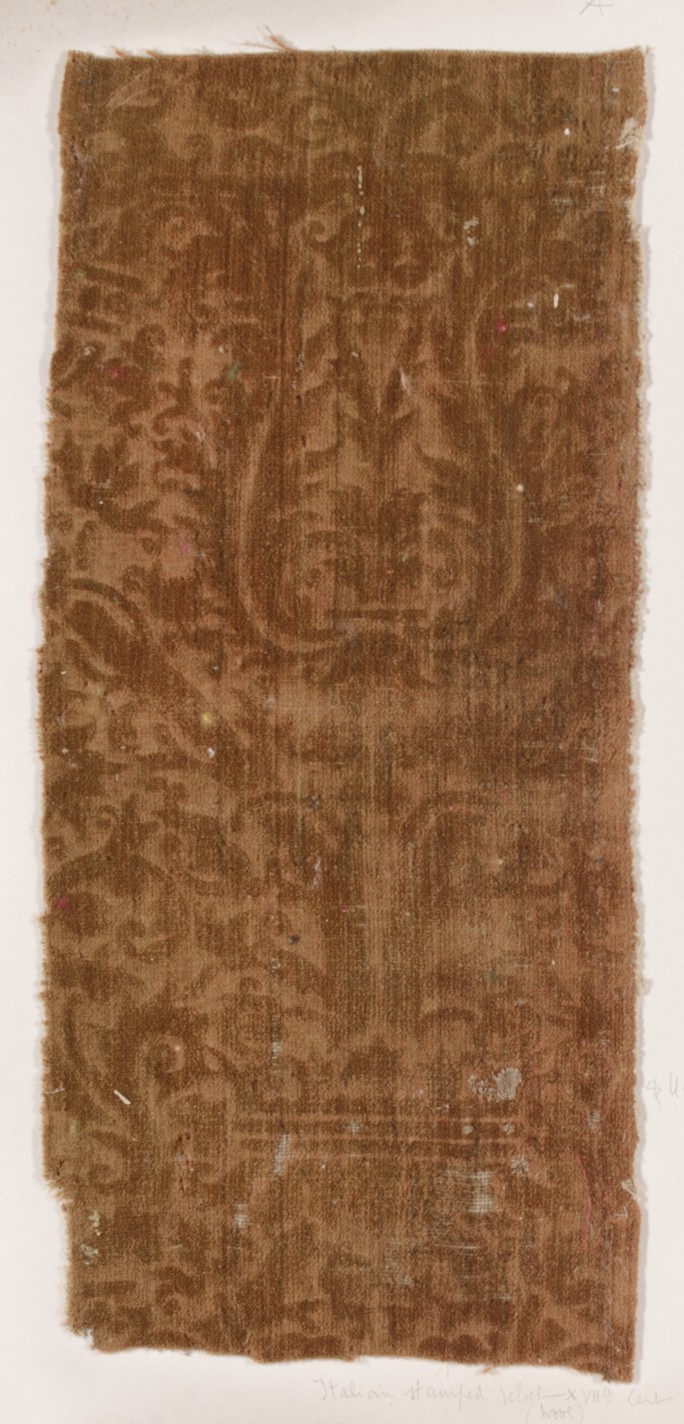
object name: fragment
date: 1601-1700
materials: wool